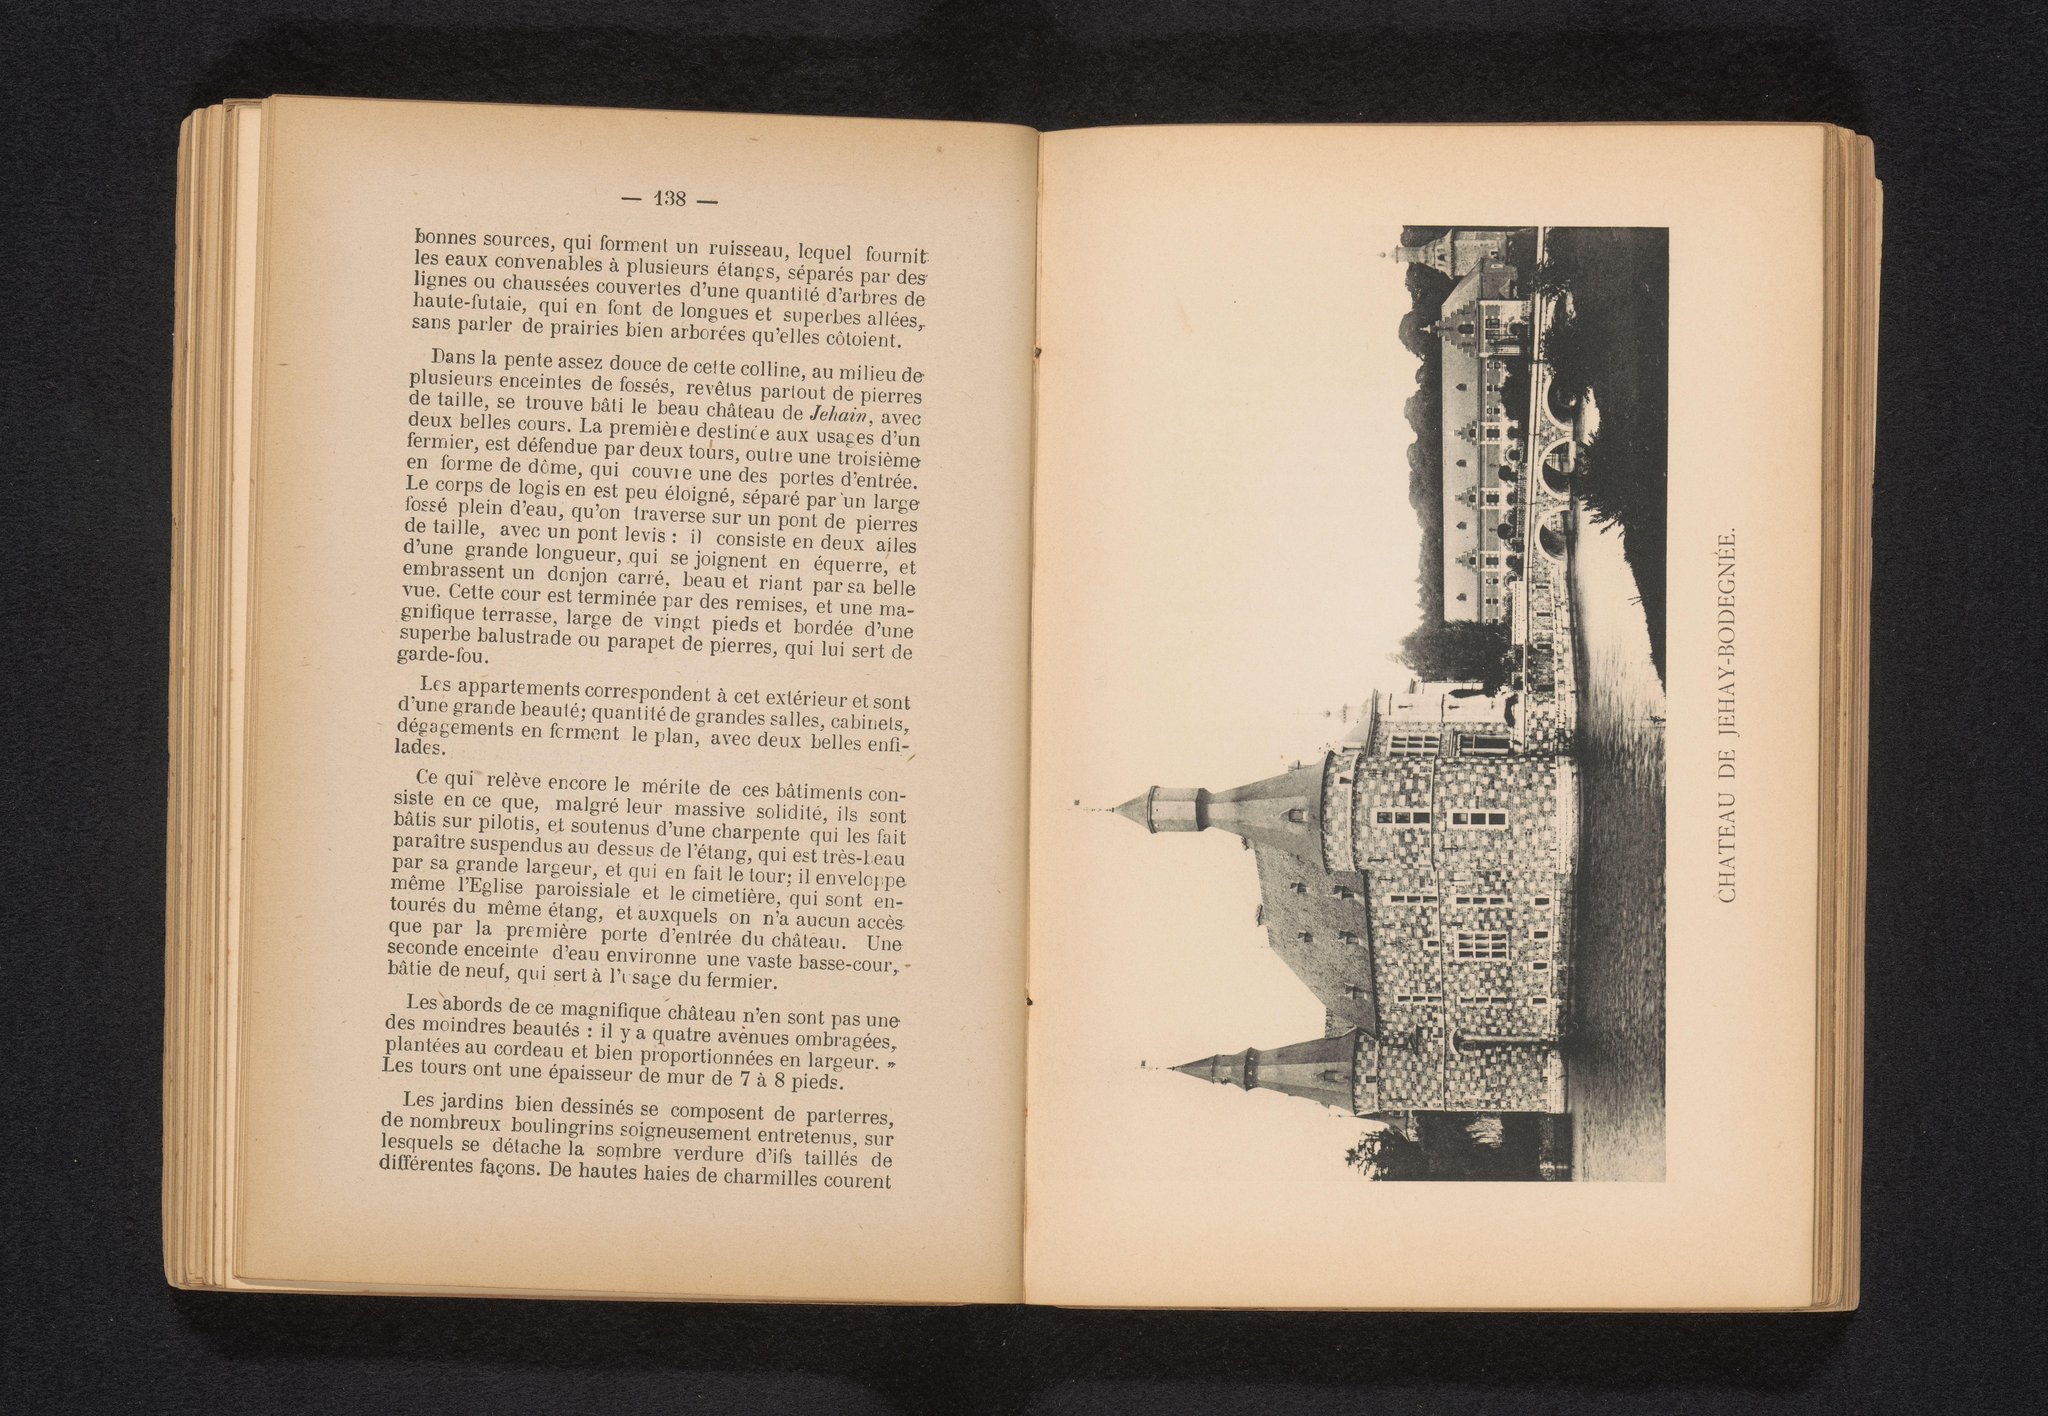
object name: photomechanical print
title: Chateau de Jehay-Bodegnee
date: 1885-1890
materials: paper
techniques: photograph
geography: amay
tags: castle